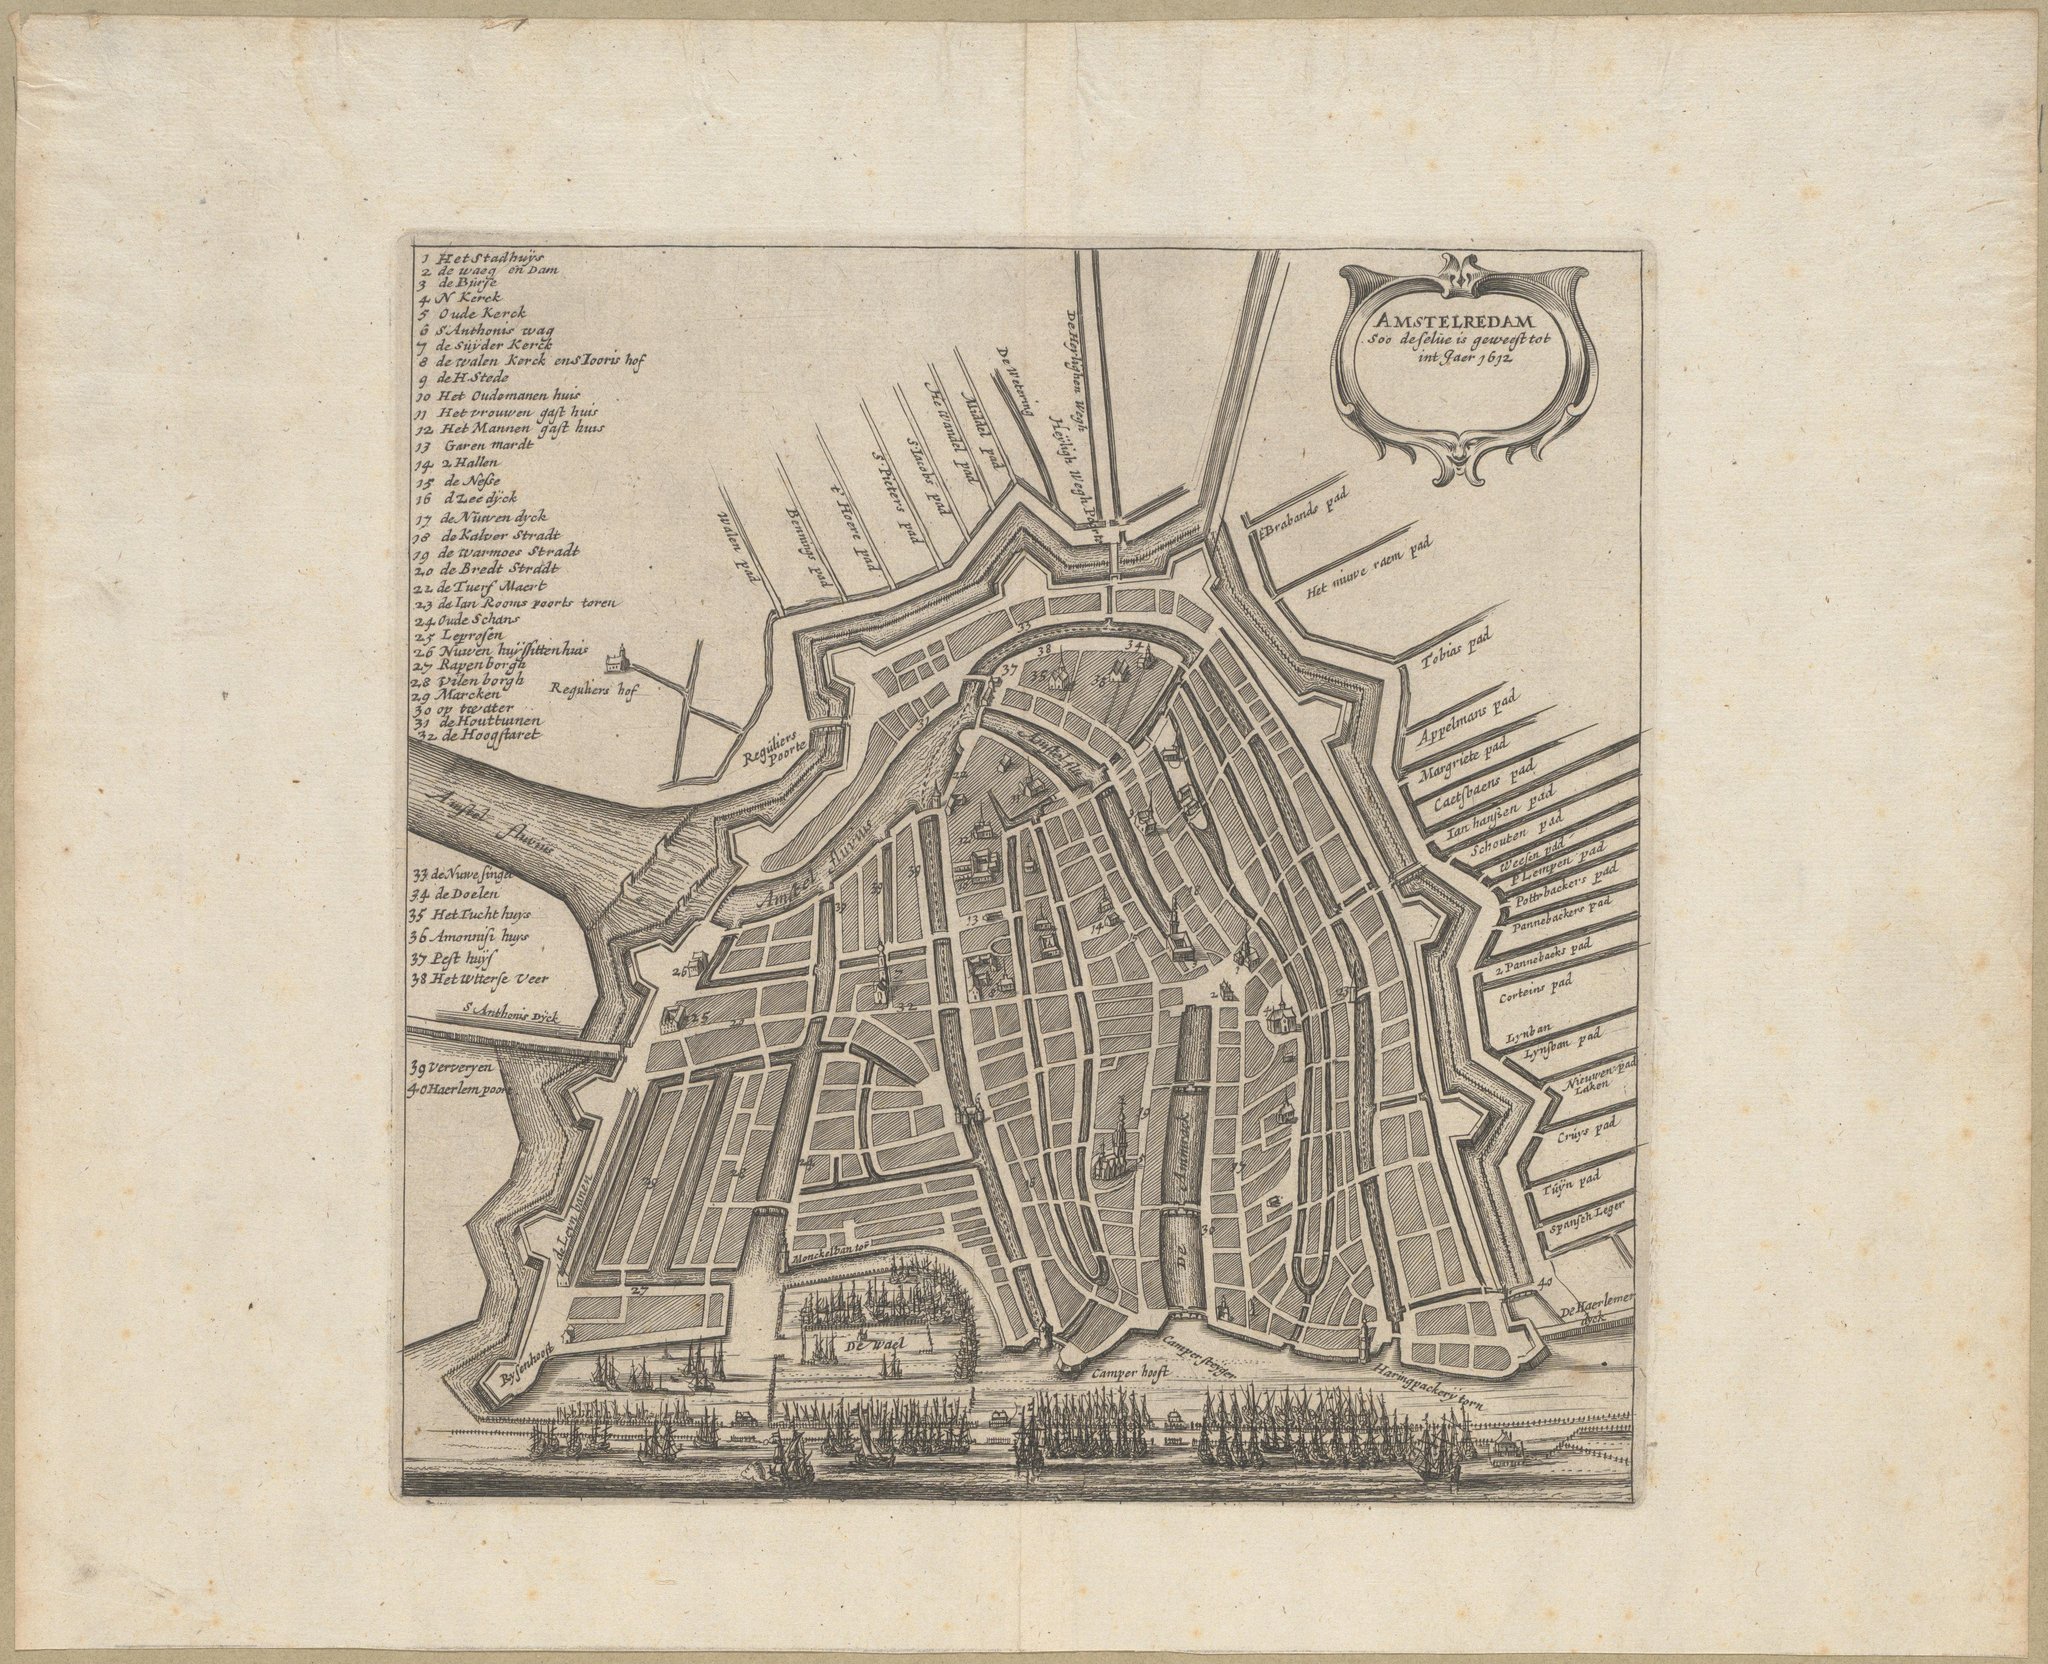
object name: print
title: Plattegrond van Amsterdam, 1612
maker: Anonymous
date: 1663-1748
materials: paper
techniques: engraving, etching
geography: northern netherlands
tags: maps of cities, amsterdam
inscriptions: collector's mark: Lugt 1641b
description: Prent gebruikt in: Handvesten, privilegien, octroyen, costumen en willekeuren der stad Amstelredam. Amsterdam: Otto Barentsz. Smient en Jodocus Smient, 1662 [i.e. 1663]. En in: Vervolg van de handvesten, privilegien, octroyen, costumen en willekeuren der stad Amstelredam (...). Amsterdam: Otto Barentsz. Smient en Bernardus Otto Smient, 1683. En in: Hand-vesten, privilegien, octroyen, costumen en willekeuren der stad Amstelredam. Amsterdam: Jan Rieuwertsz. II, 1694. En in: Handvesten, ofte privilegien ende octroyen, mitsgaders willekeuren, costuimen, ordonnantien en handelingen der stad Amstelredam (…). Amsterdam: Hendrik Janssonius van Waesberge, Petrus Schouten en Salomon Schouten, 1748.